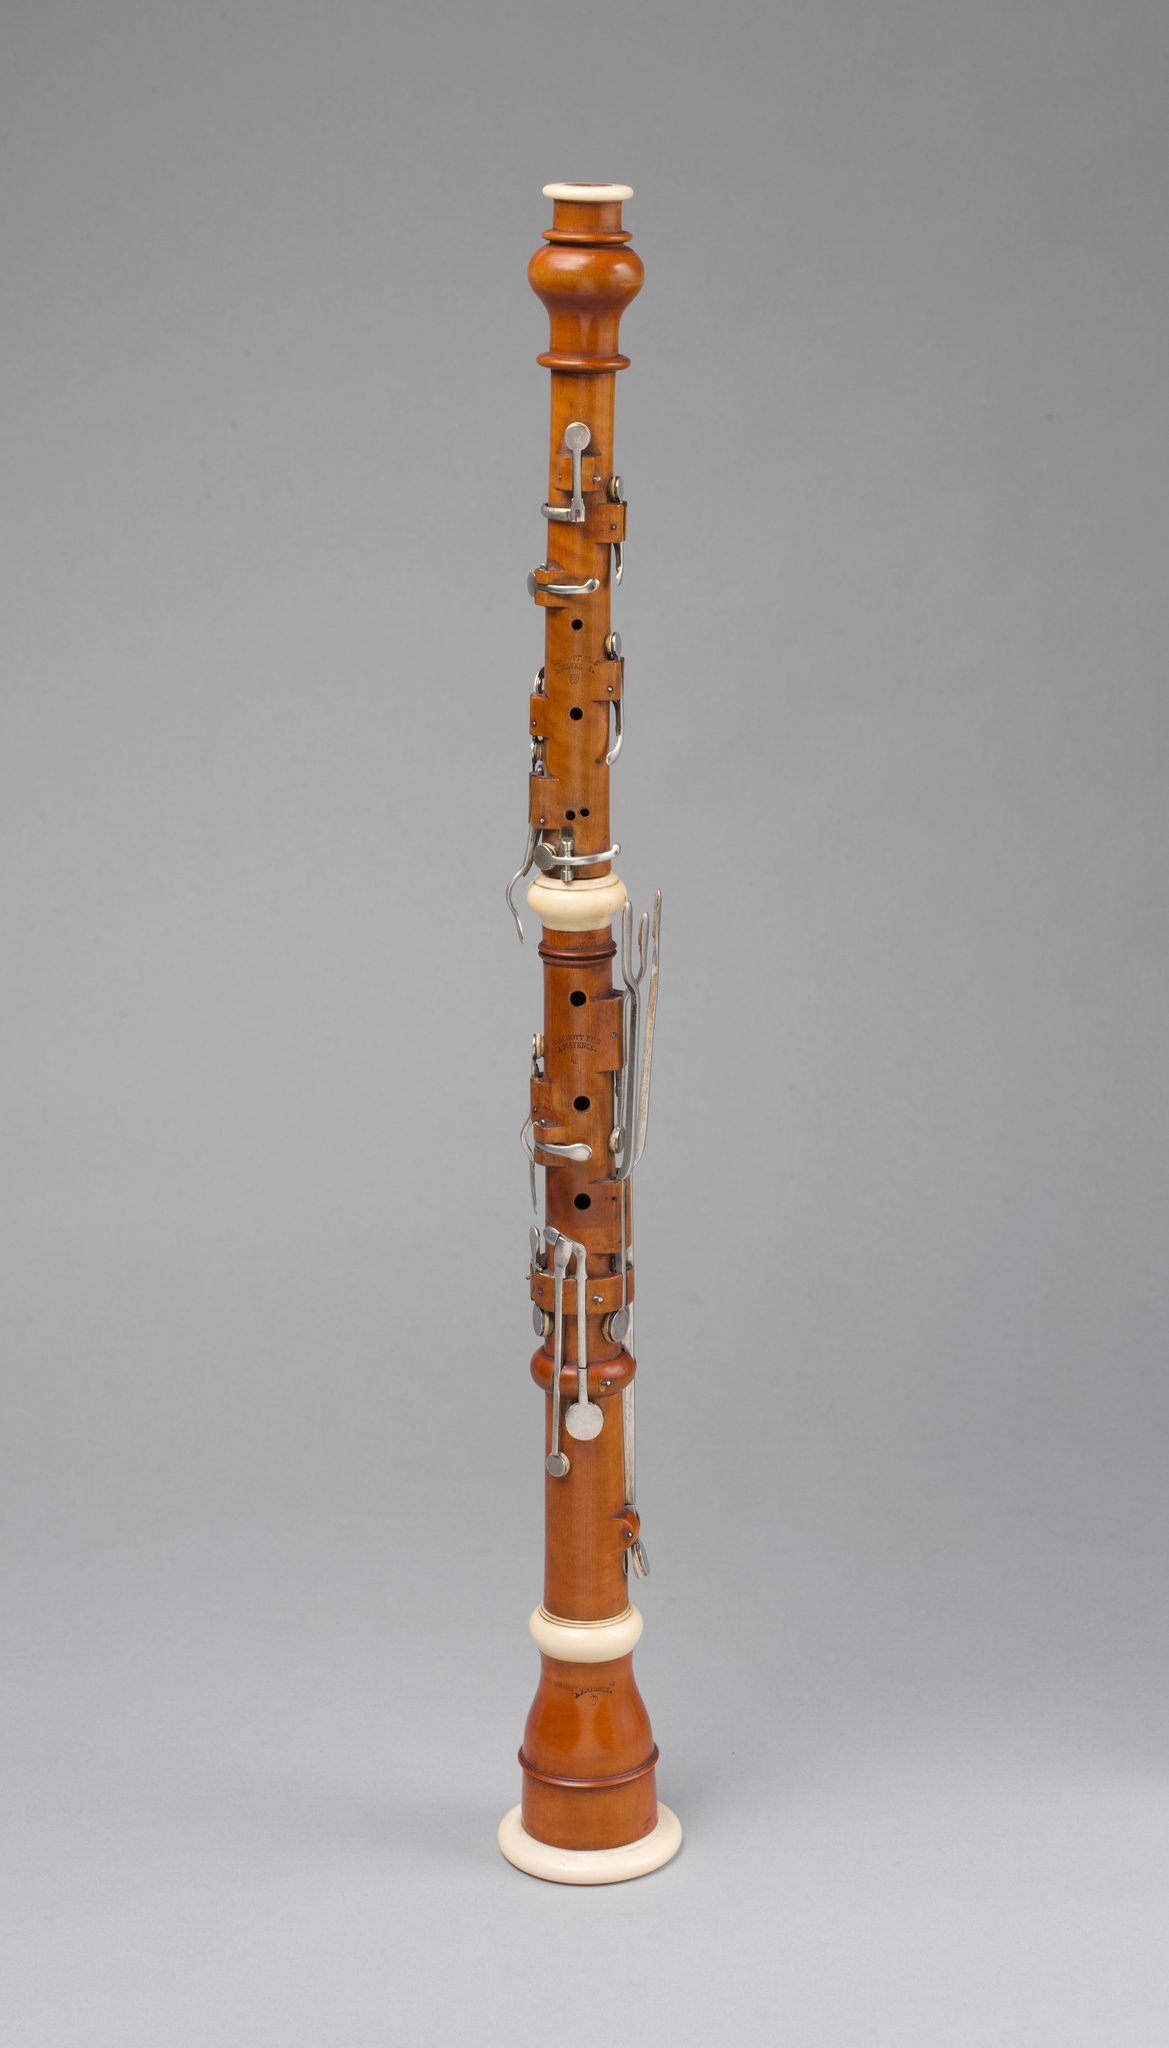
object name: oboe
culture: german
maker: b. schott fils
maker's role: manufacturer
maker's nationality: german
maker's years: 1817-1840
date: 1830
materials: wood, ivory, silver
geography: germany